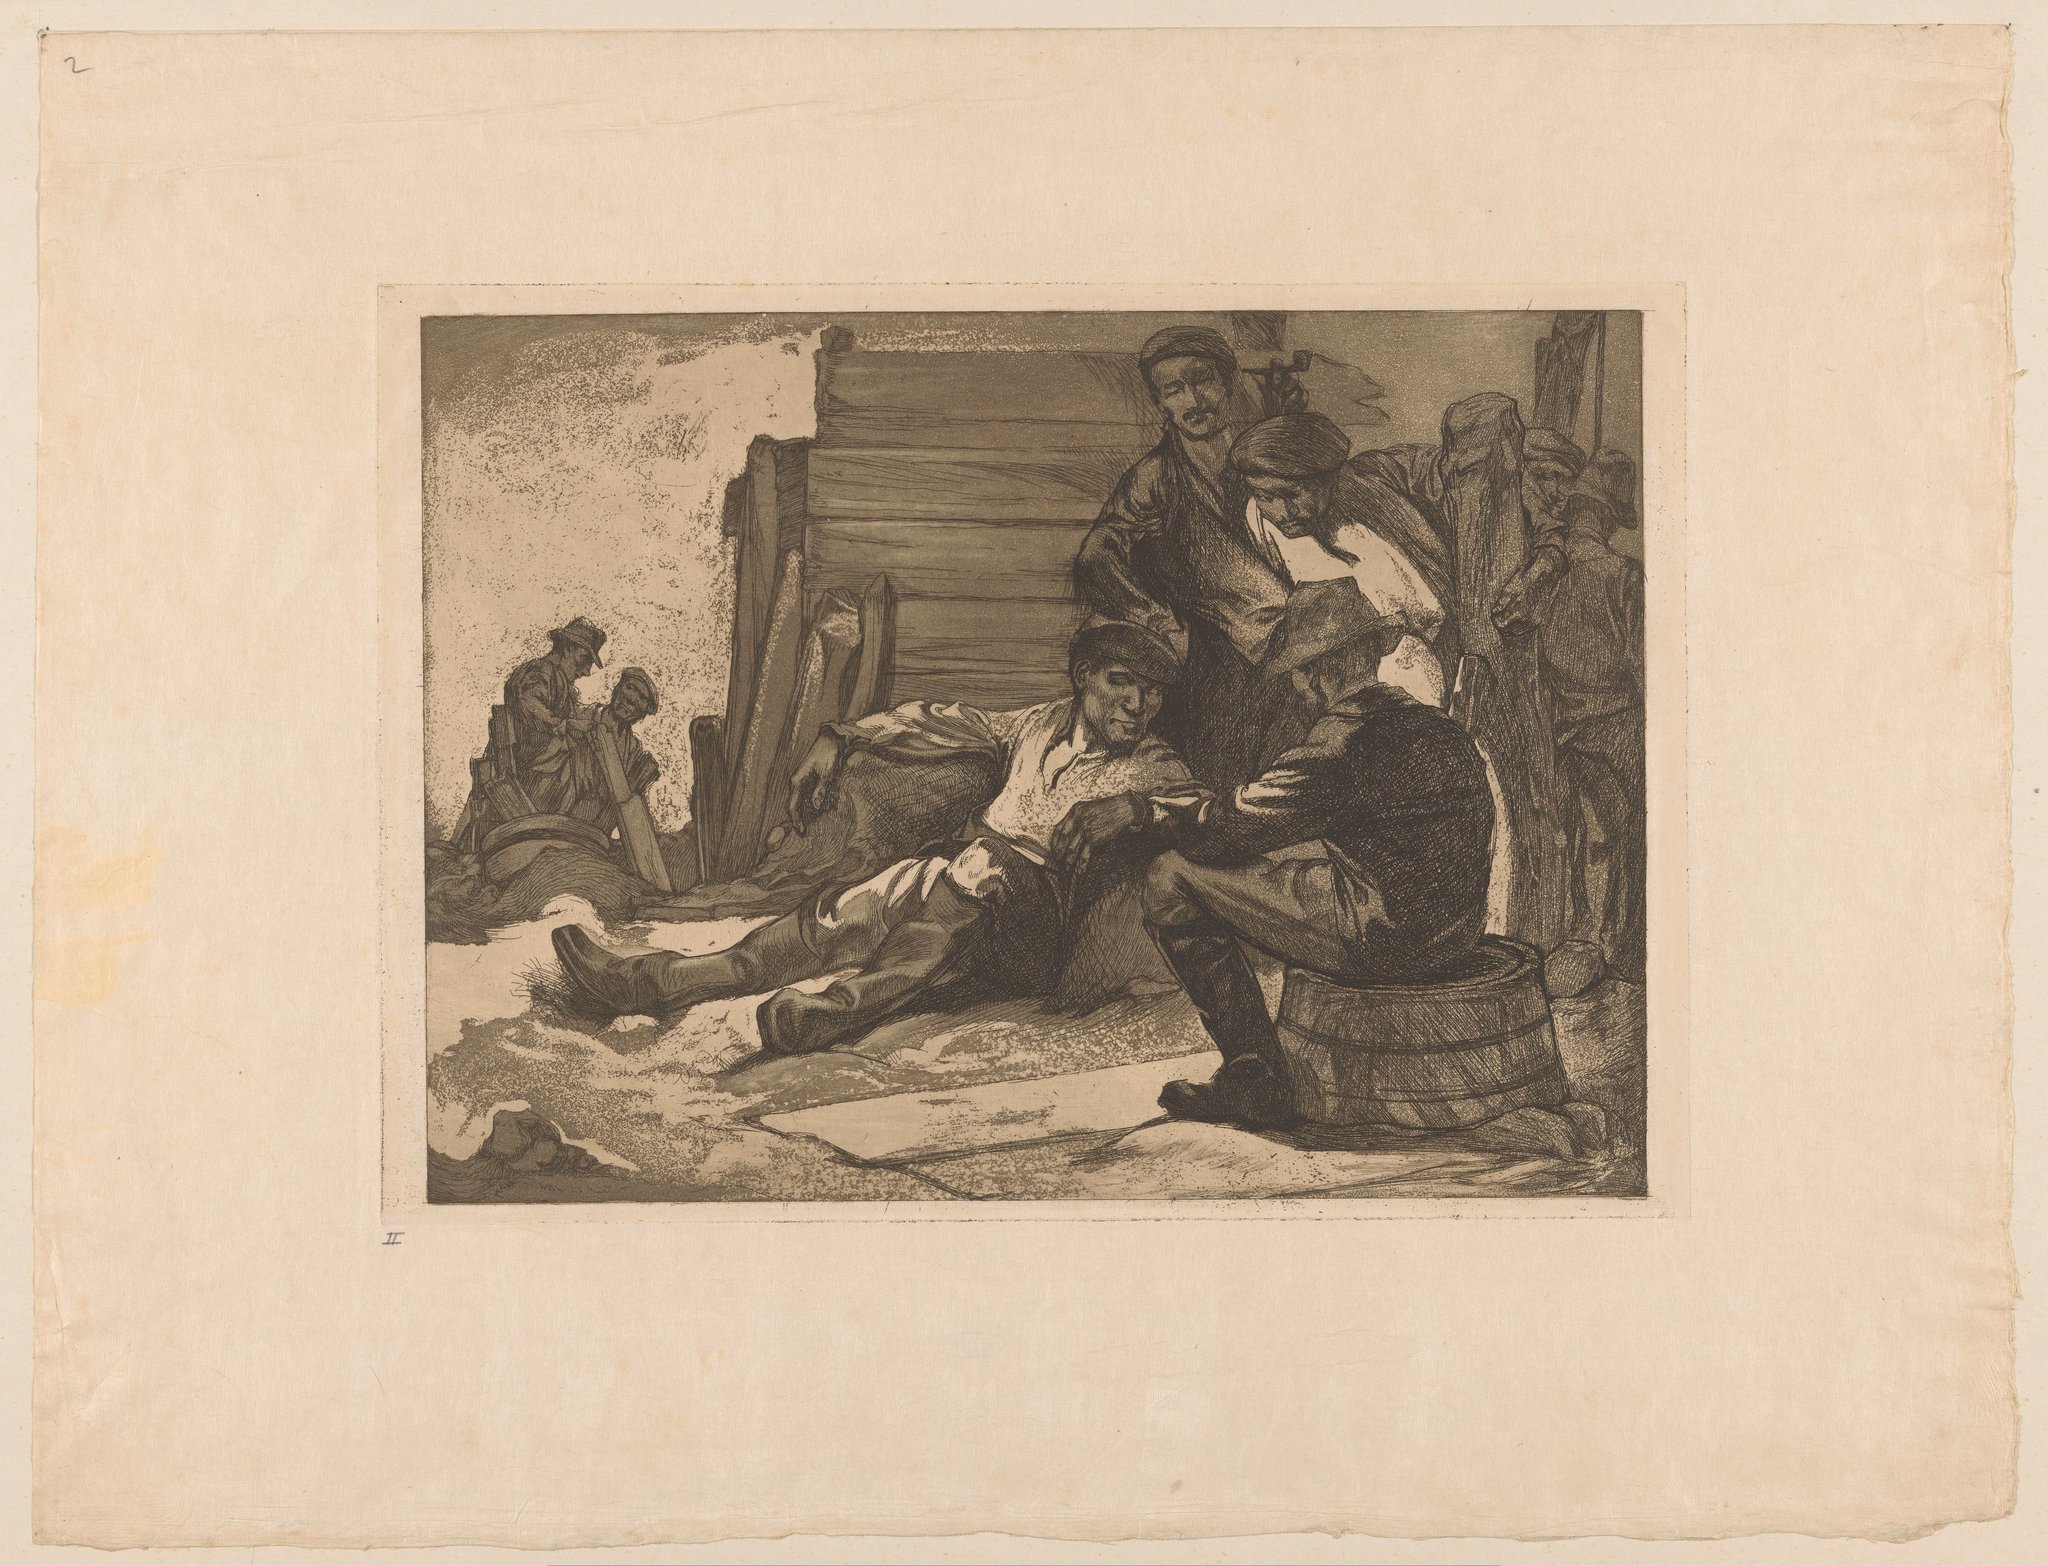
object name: print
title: Rustende arbeiders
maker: johannes josephus aarts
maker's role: draughtsman, print maker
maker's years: 1871-1934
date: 1881-1934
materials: paper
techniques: aquatint, etching, intaglio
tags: working class, labourers, resting - bb - out of doors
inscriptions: collector's mark: Lugt 2228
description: Een groep mannen in werkkleding, onder hen een man die zit op een omgekeerde kuip en een liggende man.